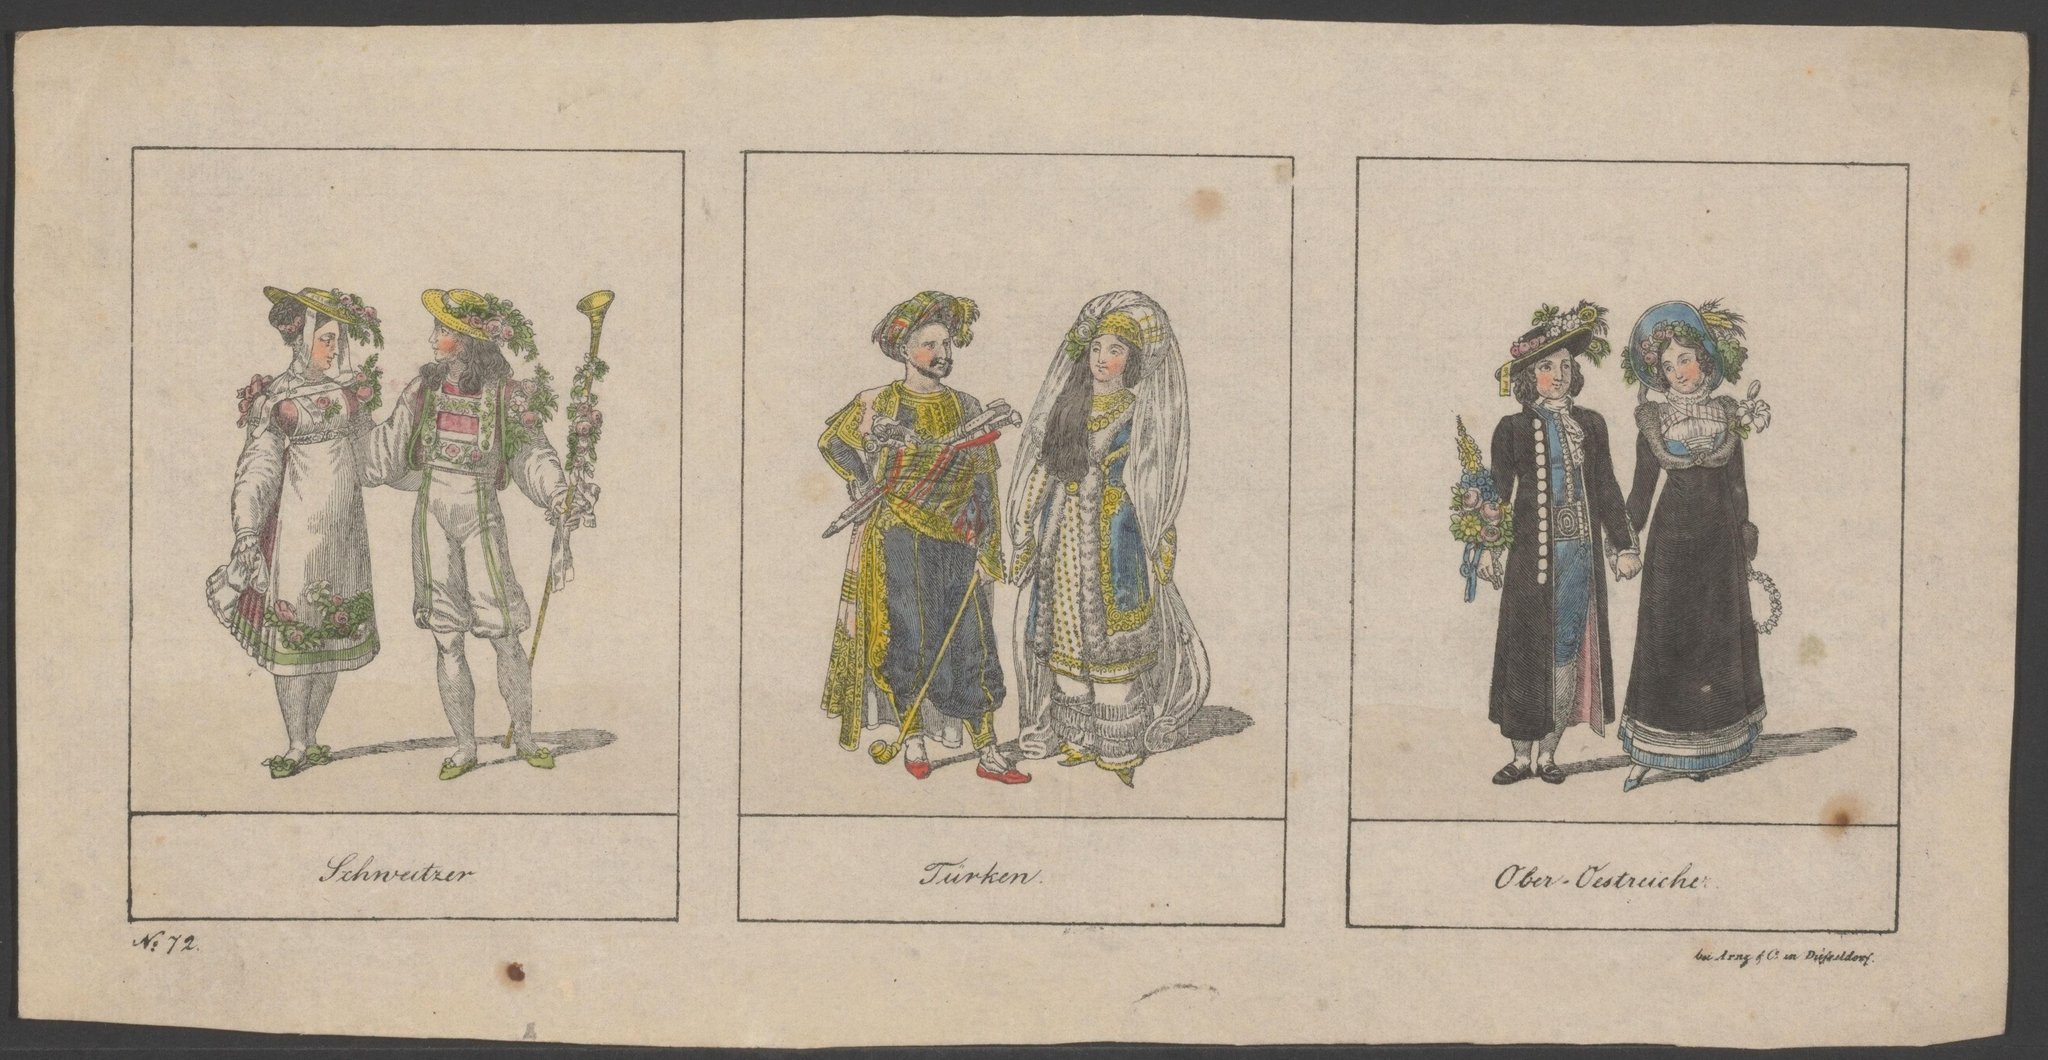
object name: print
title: Drie stellen in traditionele kostuums van Zwitsers, Turken en Oostenrijkers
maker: Anonymous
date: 1815-1858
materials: paper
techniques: engraving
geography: dusseldorf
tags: folk costume, regional costume, austria, switzerland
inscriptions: collector's mark: Lugt 1641, stamp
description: Linksonder genummerd: No. 72. Onderwerpsrubrieken binnen de Atlas Zeden en Gewoonten: Zeden en gewoonten in engeren zin, Des menschen begin, midden en einde, Kinderprenten opgeplakt op karton.